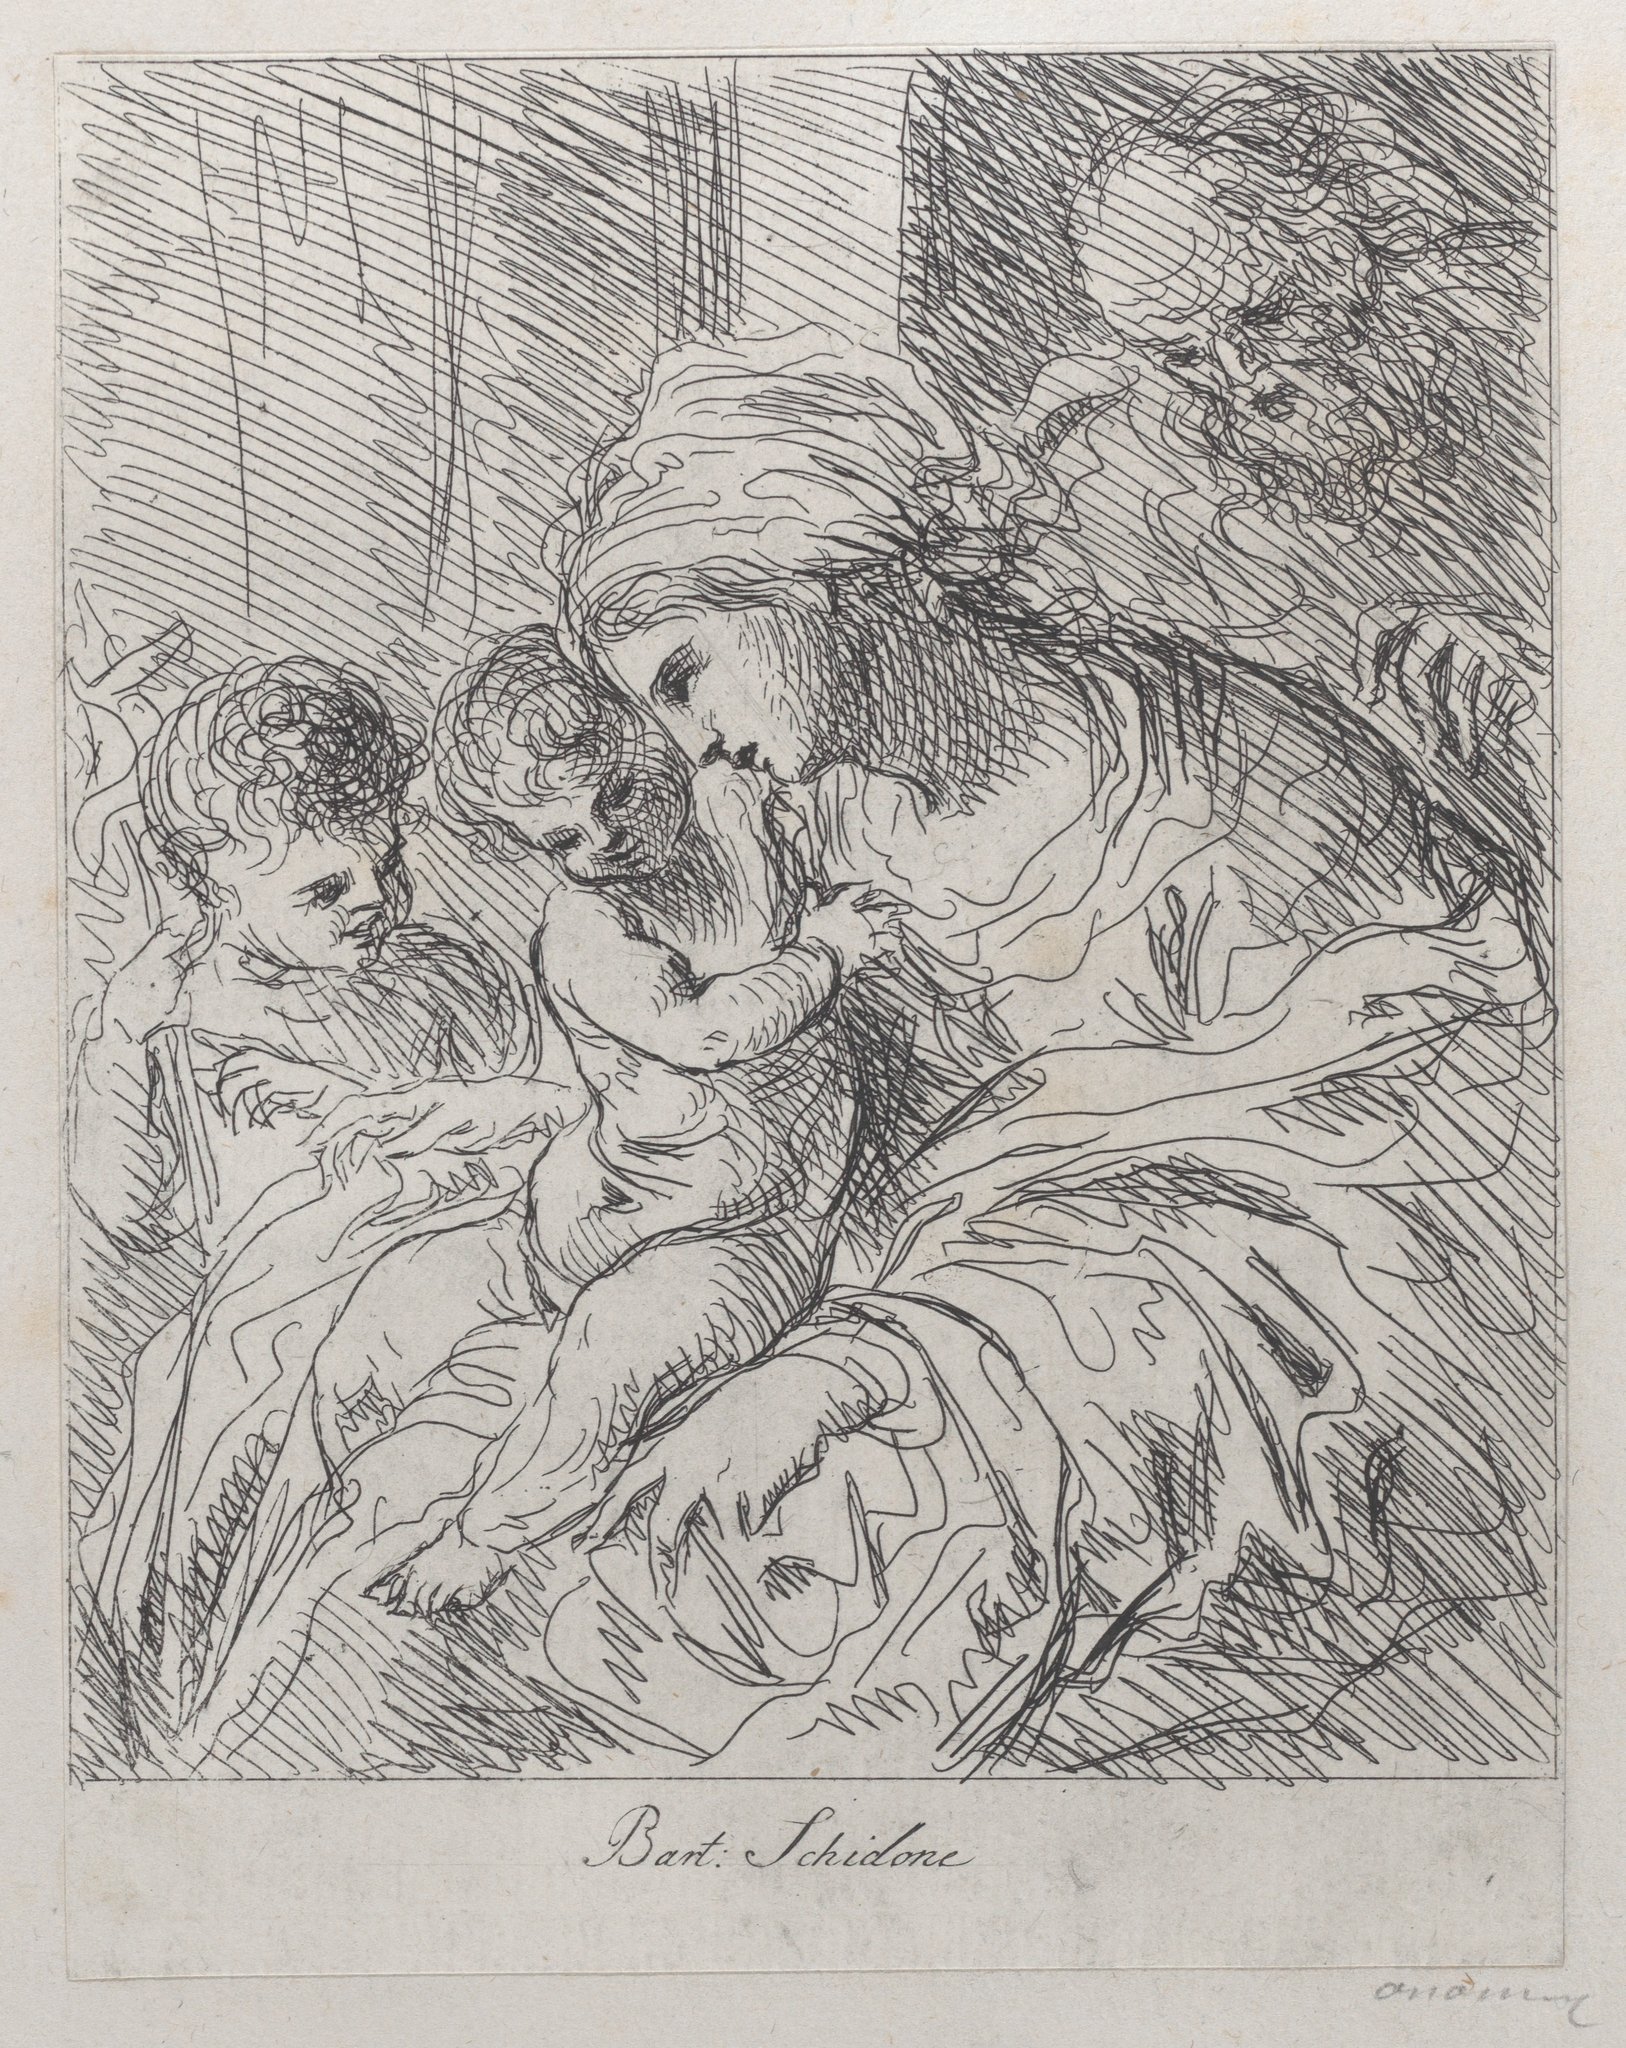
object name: print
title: The Holy Family with Saint John the Baptist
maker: Anonymous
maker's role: artist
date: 1663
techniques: etching